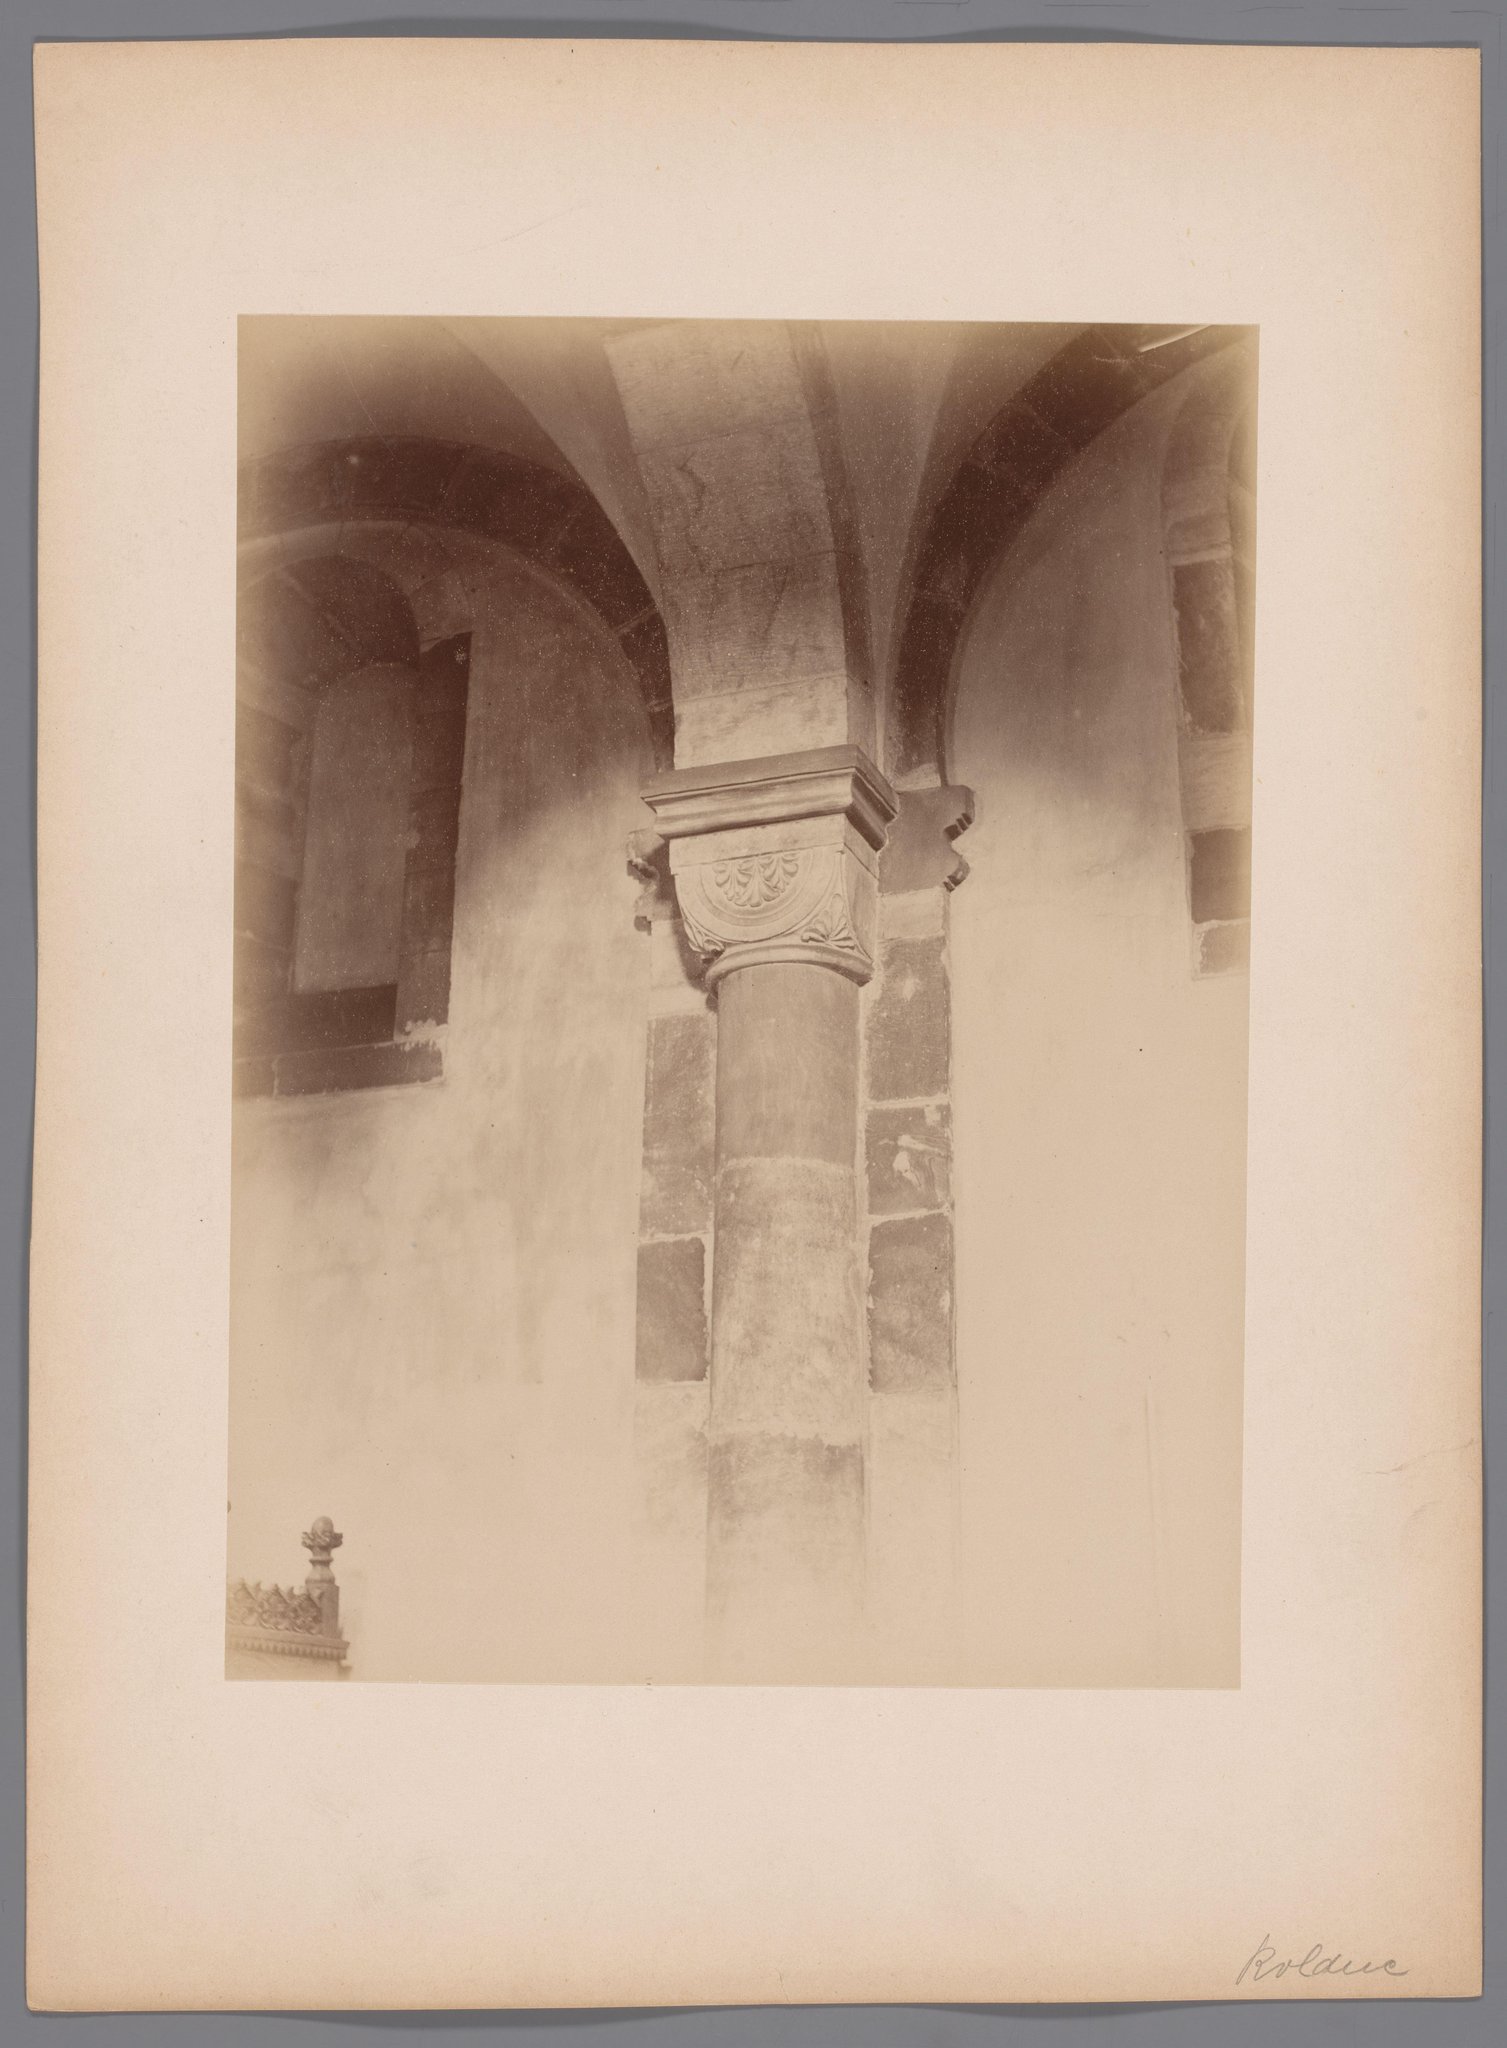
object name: photograph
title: Kapiteel van een wandkolom in de Abdijkerk te Rolduc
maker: anoniem (monumentenzorg)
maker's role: fotograaf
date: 1890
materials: cardboard, photographic support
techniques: albumen print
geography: rolduc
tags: capital (~ column, pillar)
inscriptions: annotation: ‘Rolduc’, annotation: ‘Kapiteel van een der wandkolommen in de kerk te Rolduc/ oct 1980’